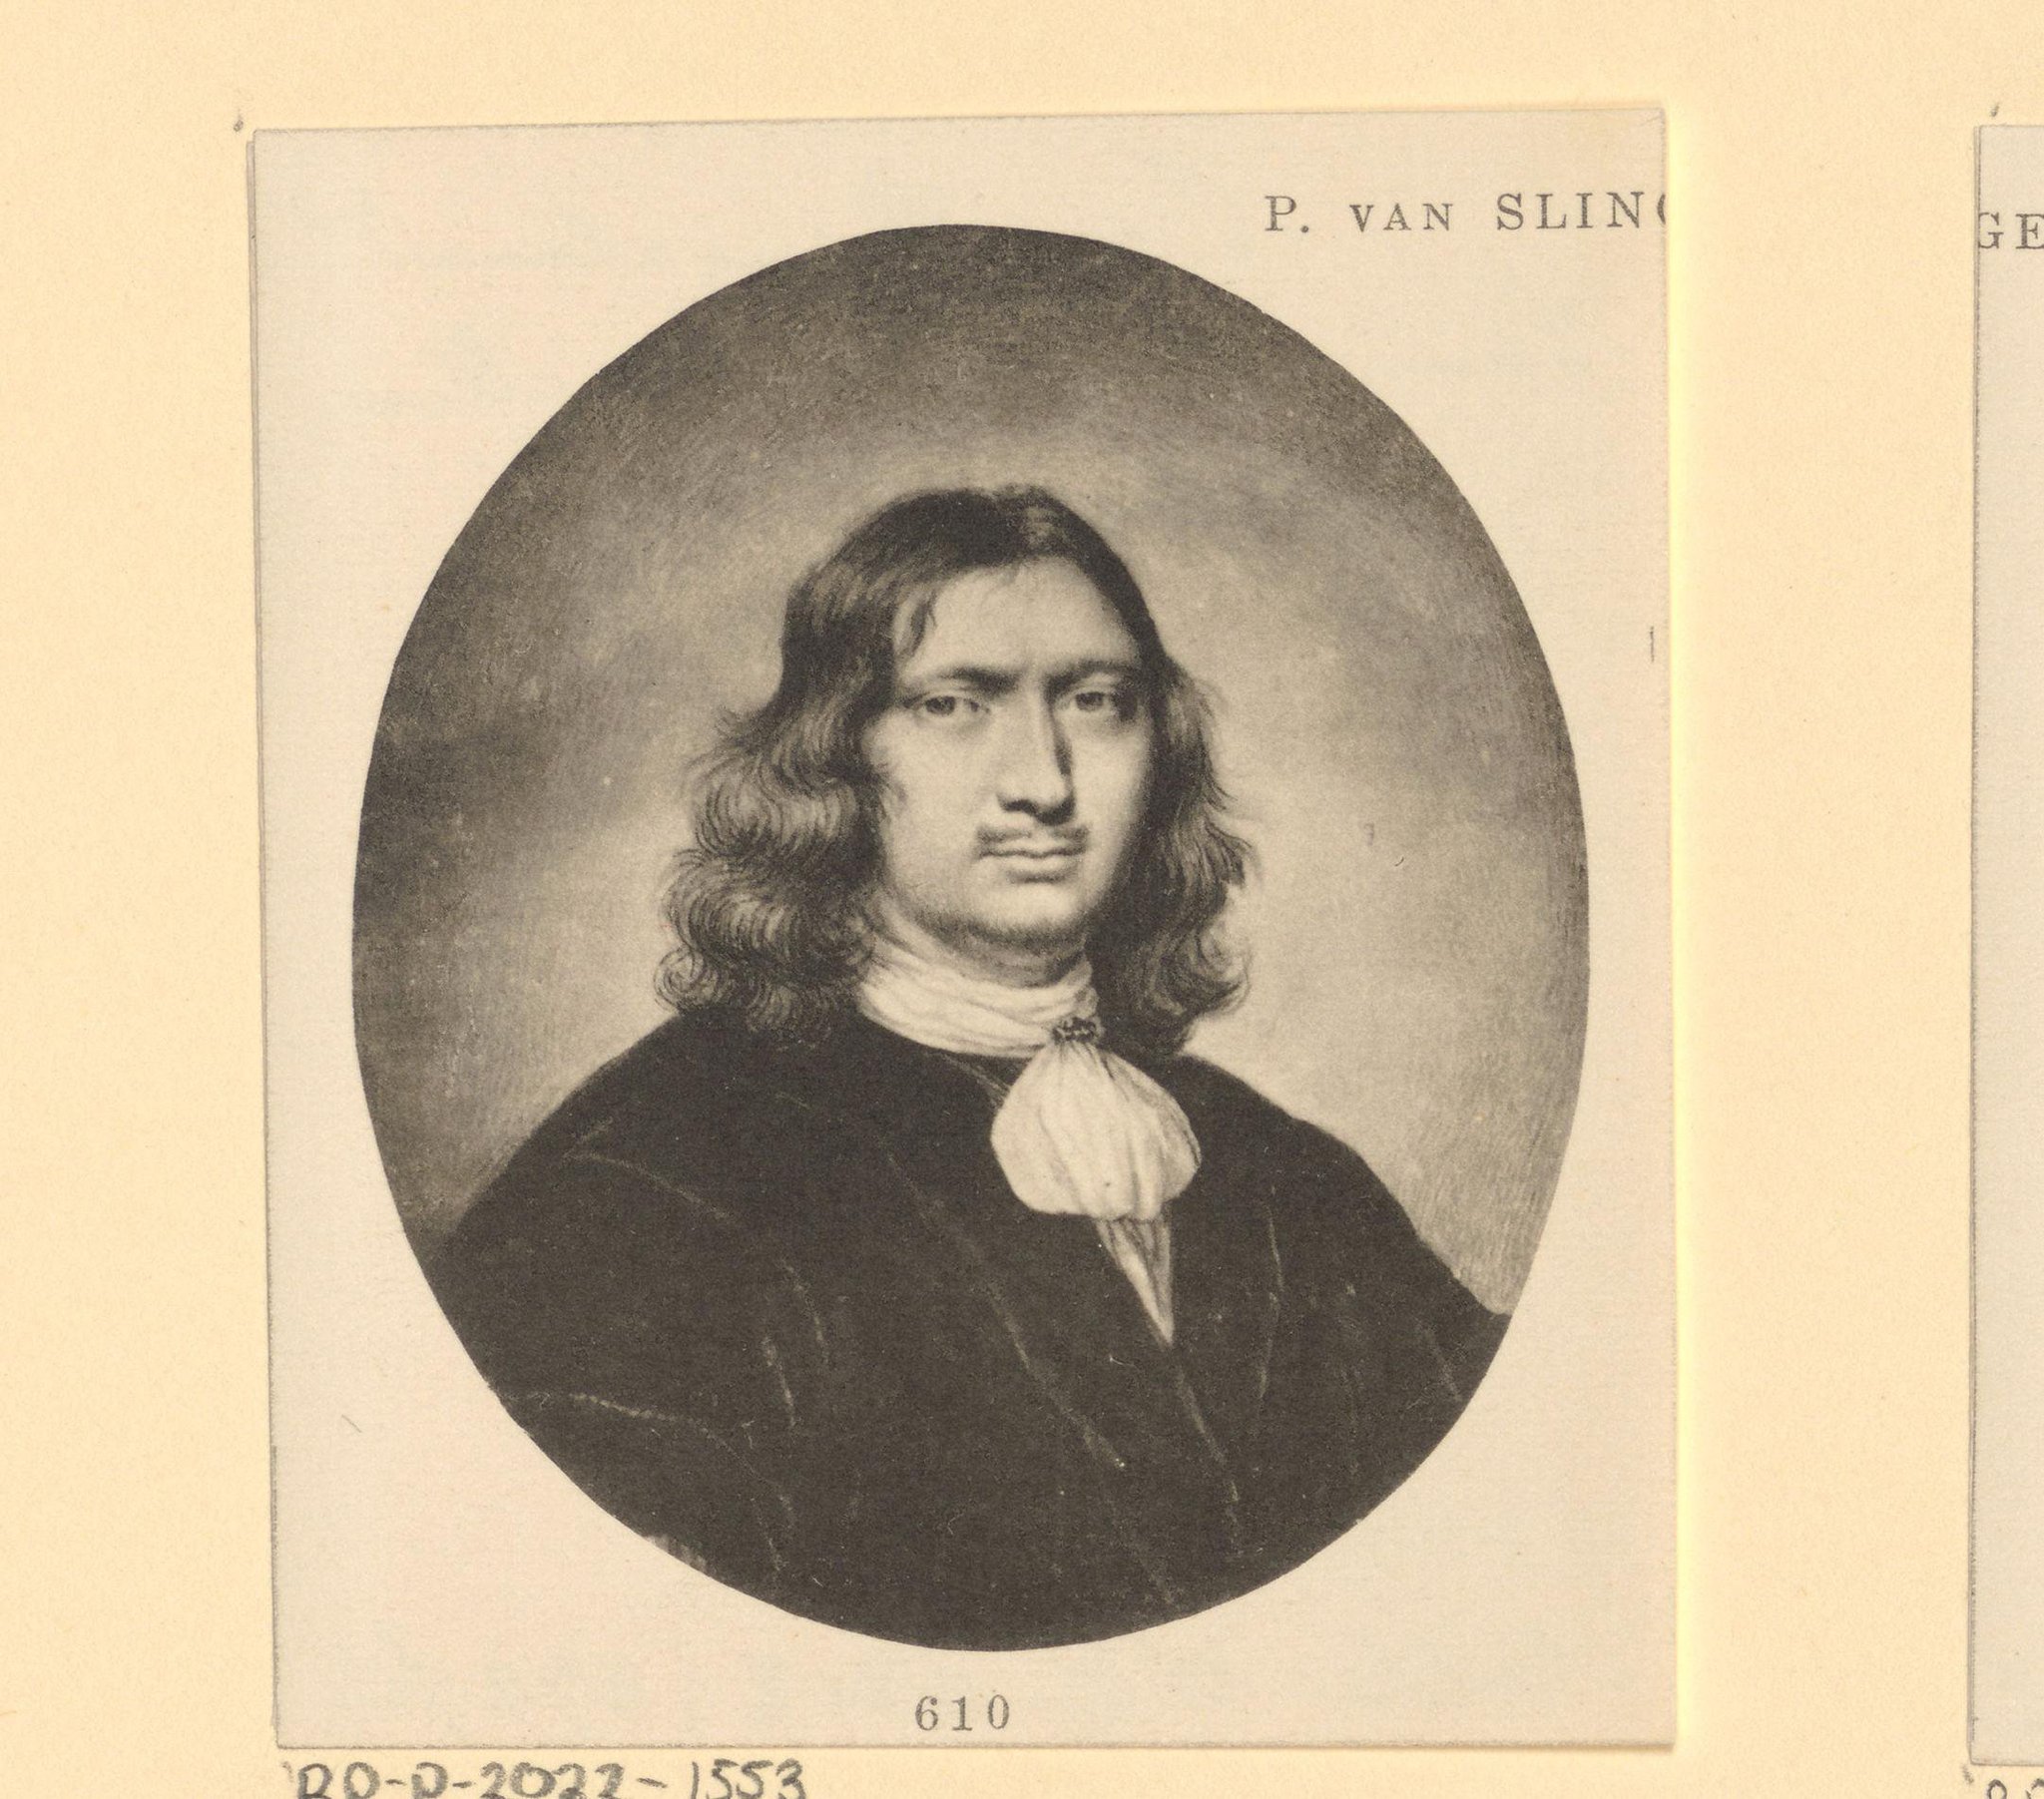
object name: photomechanical print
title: Portret van Samuel Joosten van Musschenbroek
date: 1875-1930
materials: paper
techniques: photograph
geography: leiden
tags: leiden, historical persons